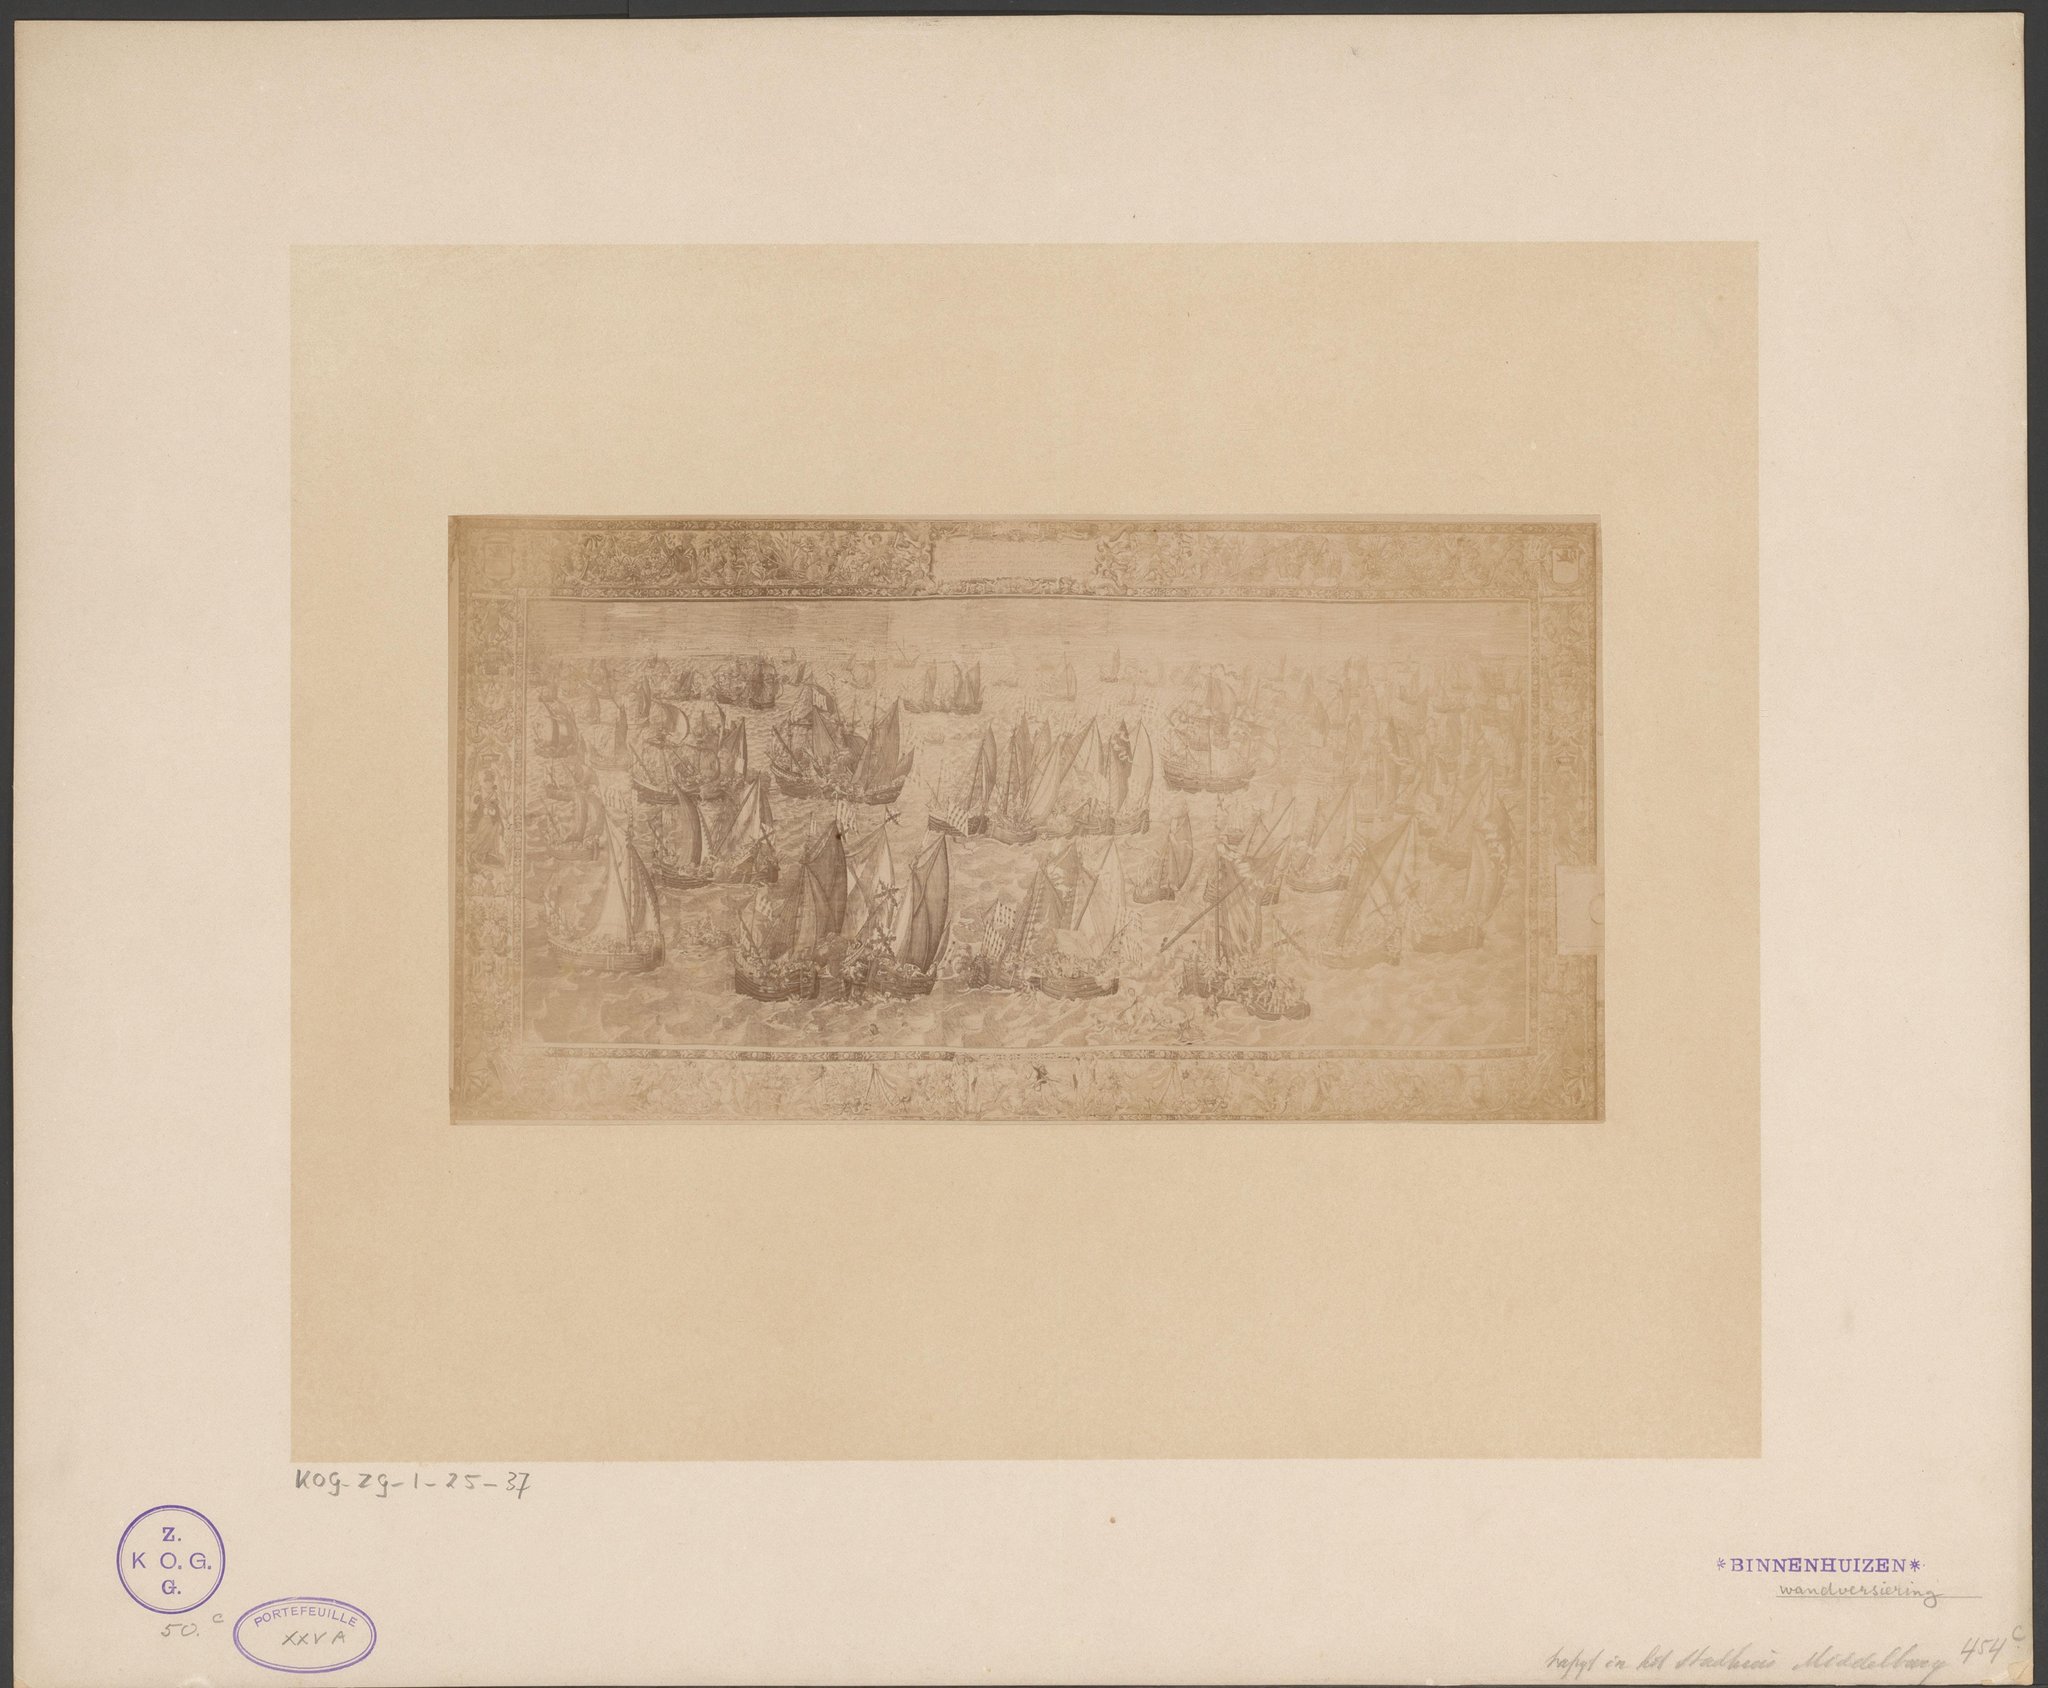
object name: photograph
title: Wandtapijt met de Slag bij Bergen op Zoom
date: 1860-1900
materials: paper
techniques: albumen print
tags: tapestry, armorial bearing, heraldry, bergen op zoom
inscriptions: stamp, stamp, collector's mark: Lugt 1641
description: Wandtapijt uit het stadhuis van Middelburg. Onderwerpsrubrieken binnen de Atlas Zeden en Gewoonten: Zeden en Gewoonten in Engeren Zin, De Woning, Binnenhuizen, Wandversiering.